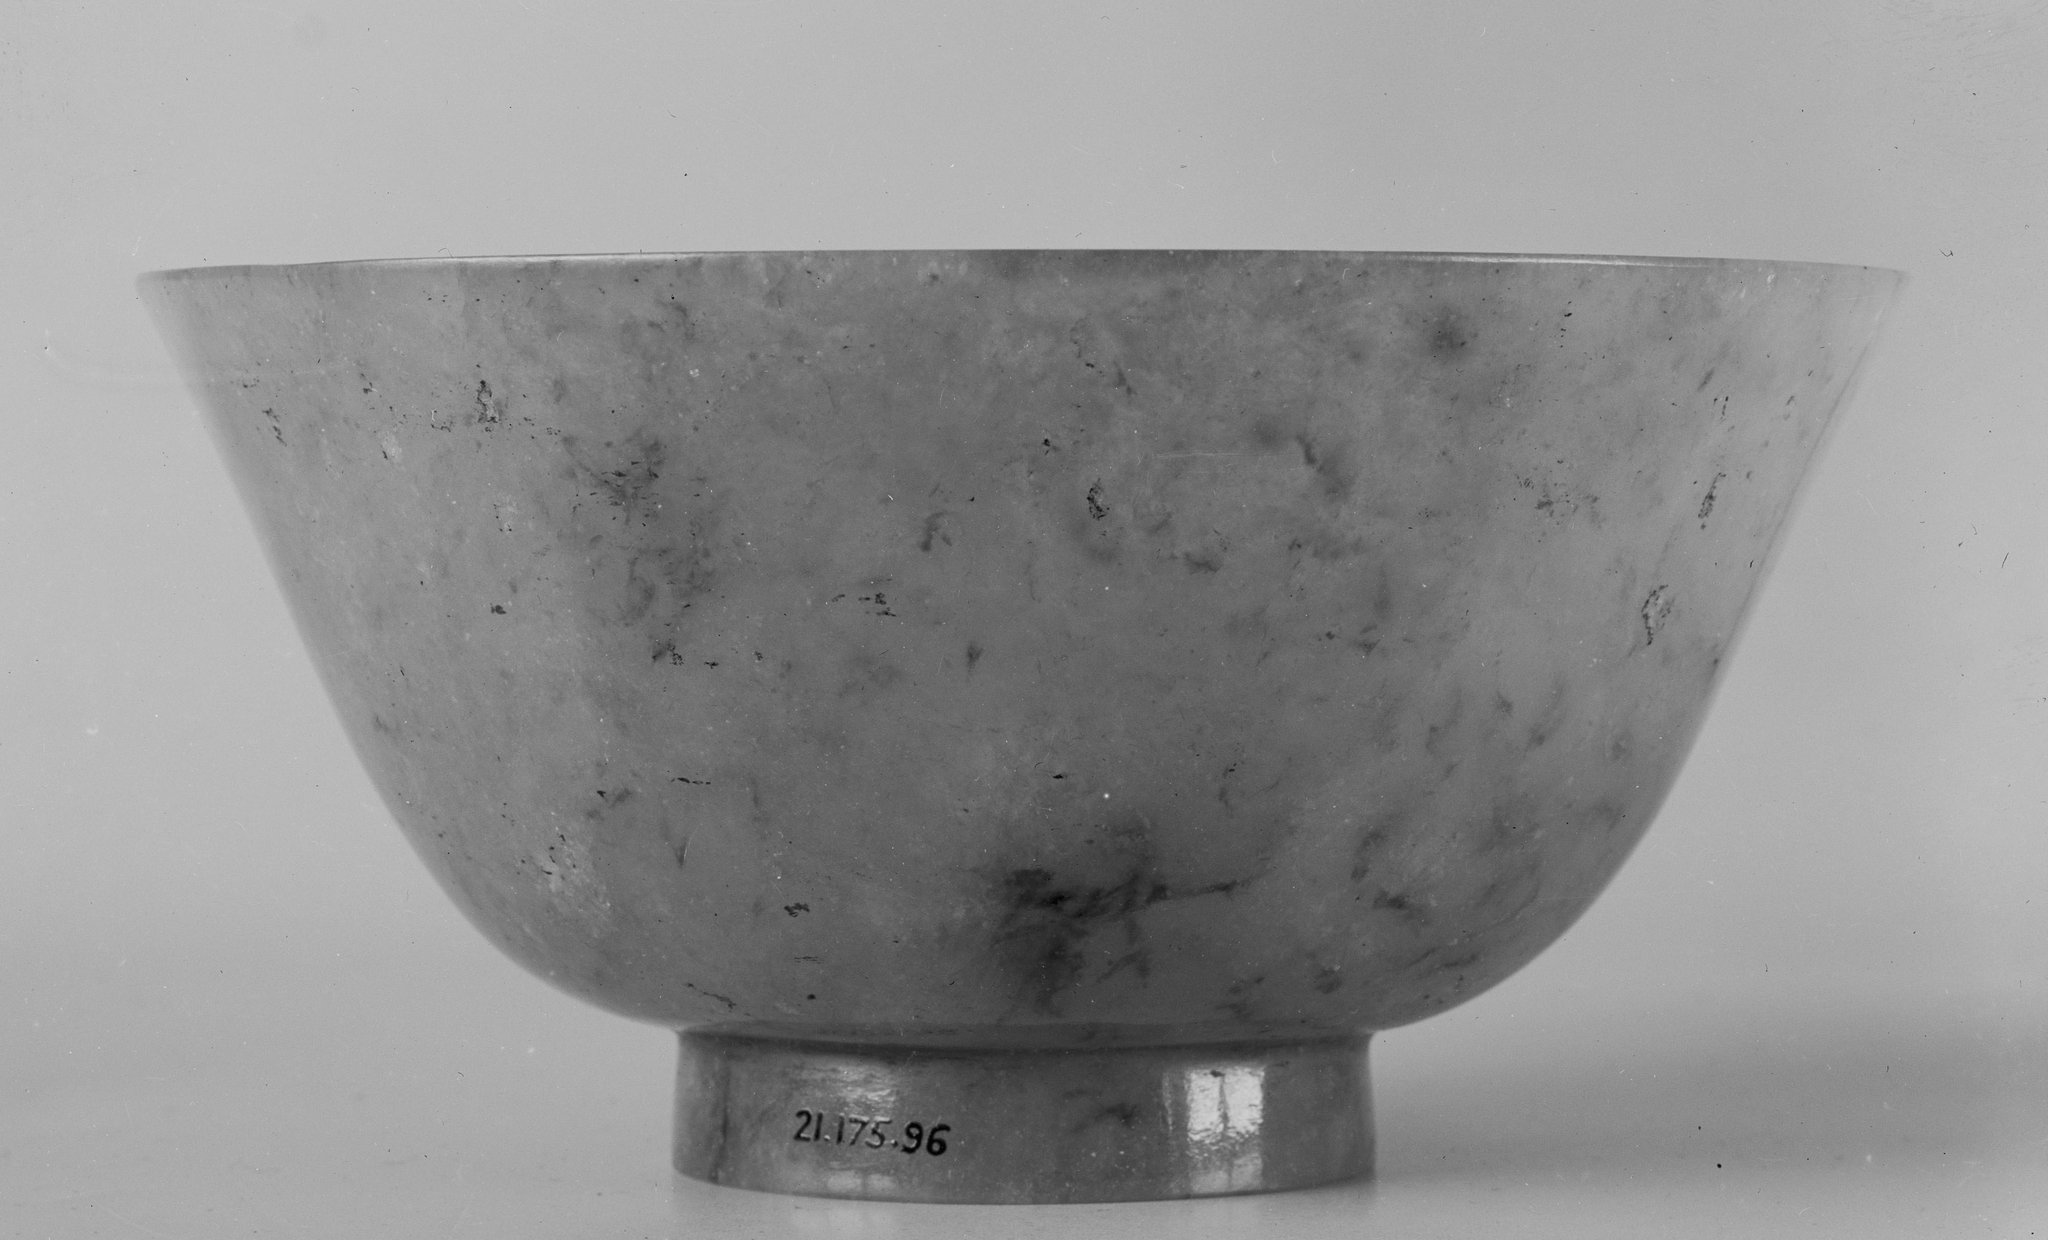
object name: bowl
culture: chinese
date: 1701-1800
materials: jade